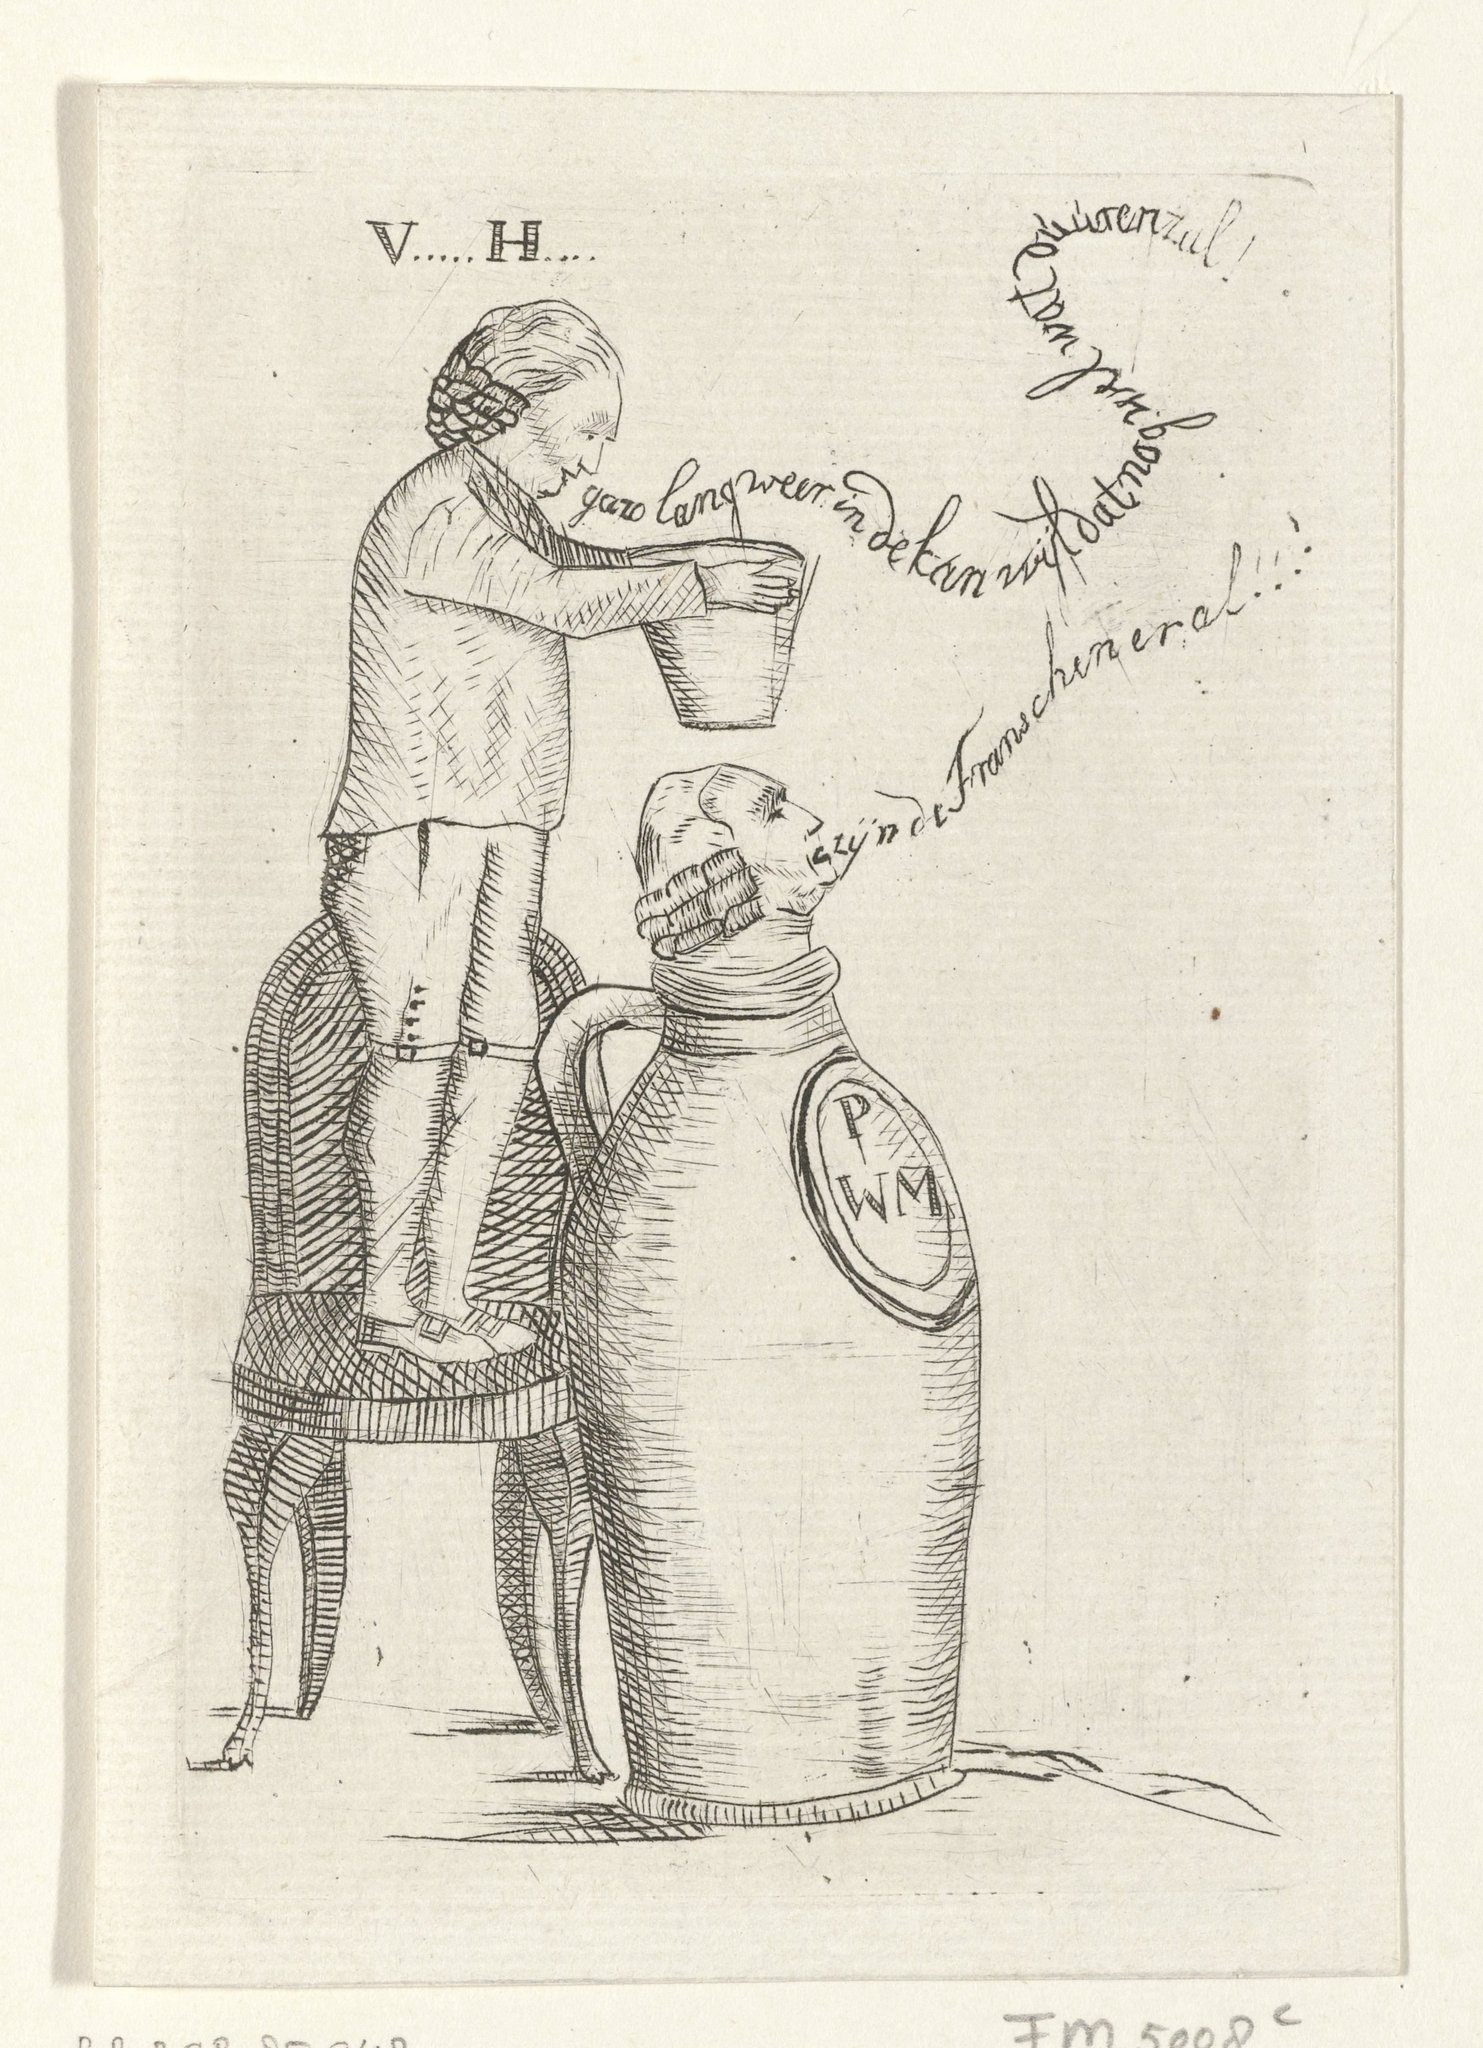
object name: print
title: Spotprent op Pieter Witmond, 1787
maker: Anonymous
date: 1787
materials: paper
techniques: engraving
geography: northern netherlands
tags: container of ceramics: jar, jug, pot, vase, political caricatures and satires, amsterdam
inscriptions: collector's mark: Lugt 2228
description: Spotprent op de Amsterdamse patriotse afgevaardigde en aardewerkverkoper Pieter Witmond, 1787. Alleen het hoofd van Witmond steekt uit een kruik gemerkt PWM. Een onbekende man (gemerkt V... H...) staat op een stoel achter de kan en wil de stop in de kruik stoppen. Met opschriften.